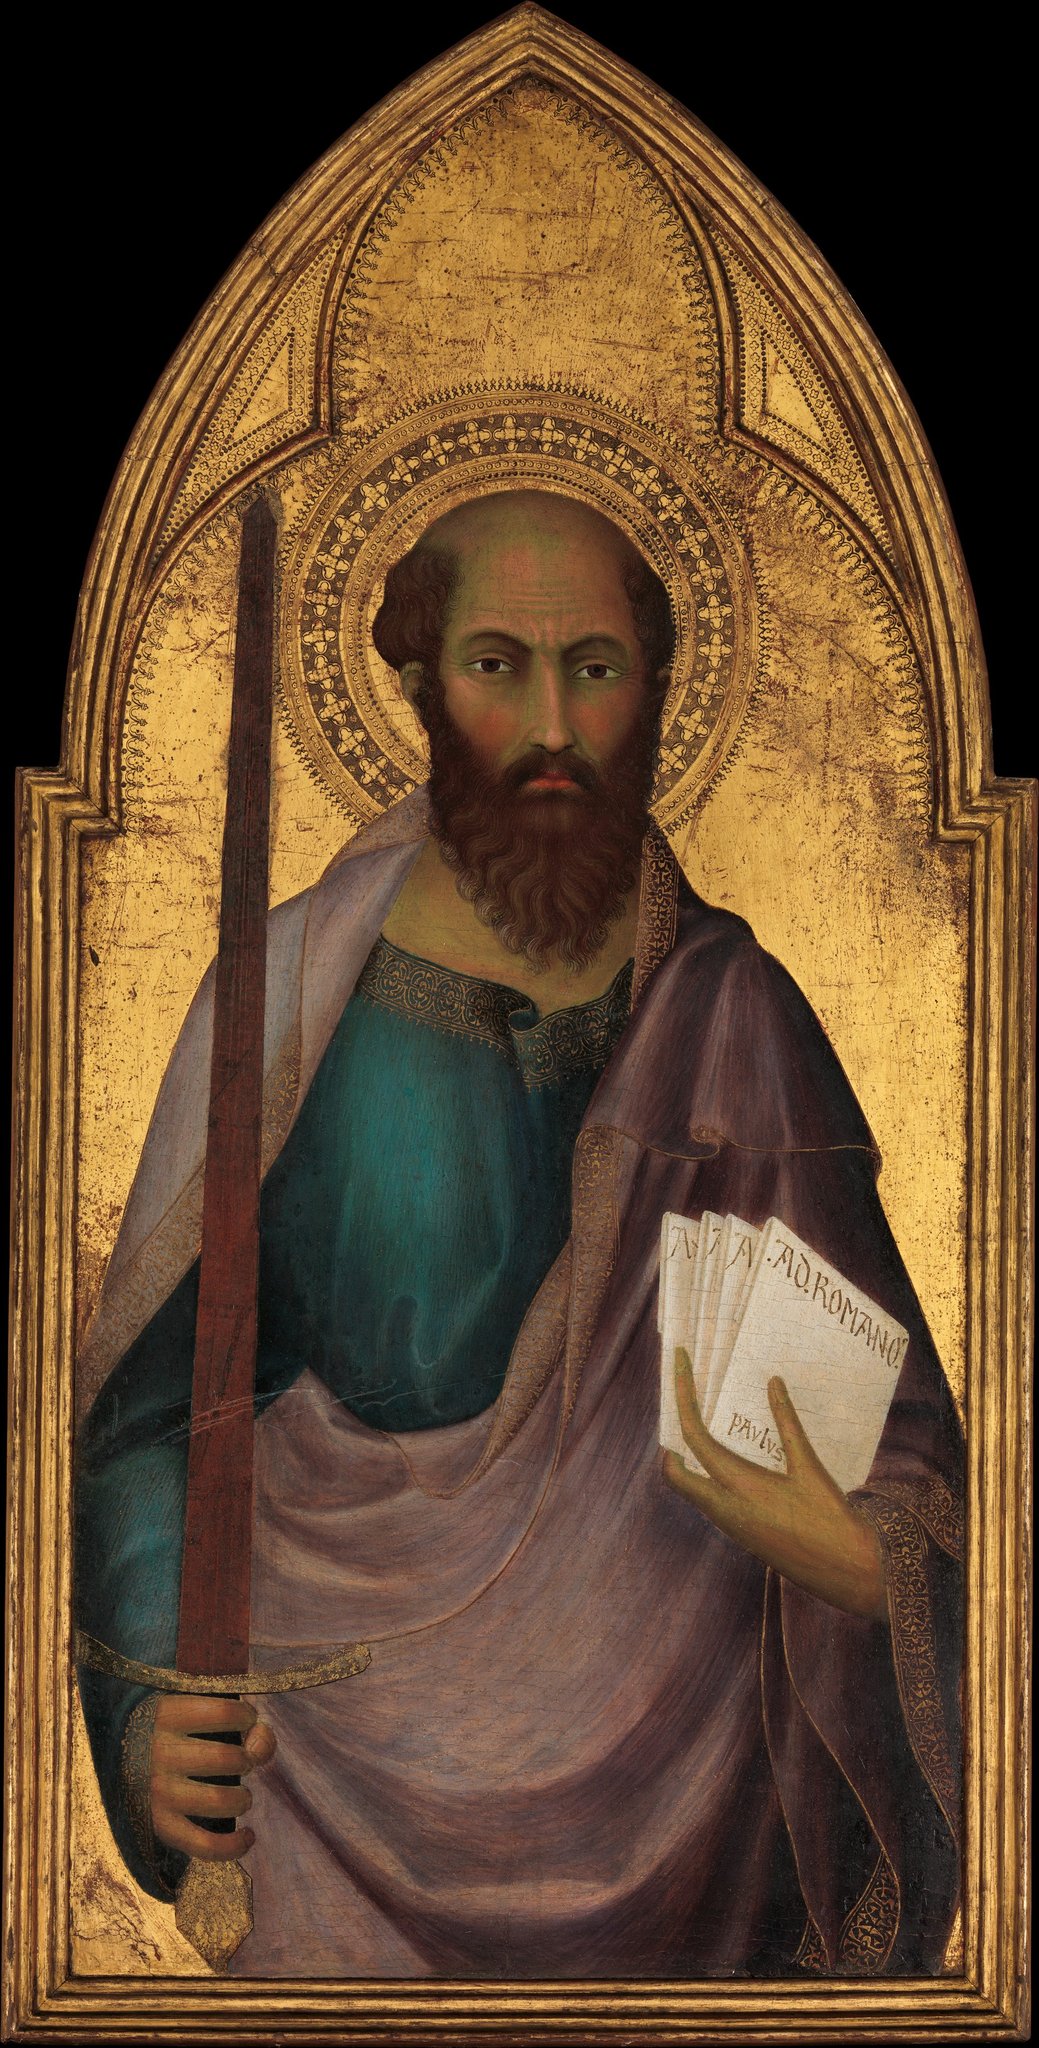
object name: painting, part of an altarpiece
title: Saint Paul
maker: lippo memmi (filippo di memmo)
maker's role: artist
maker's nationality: italian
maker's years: 1317-1356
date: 1330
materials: gold leaf, paint, wood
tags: swords,saint paul